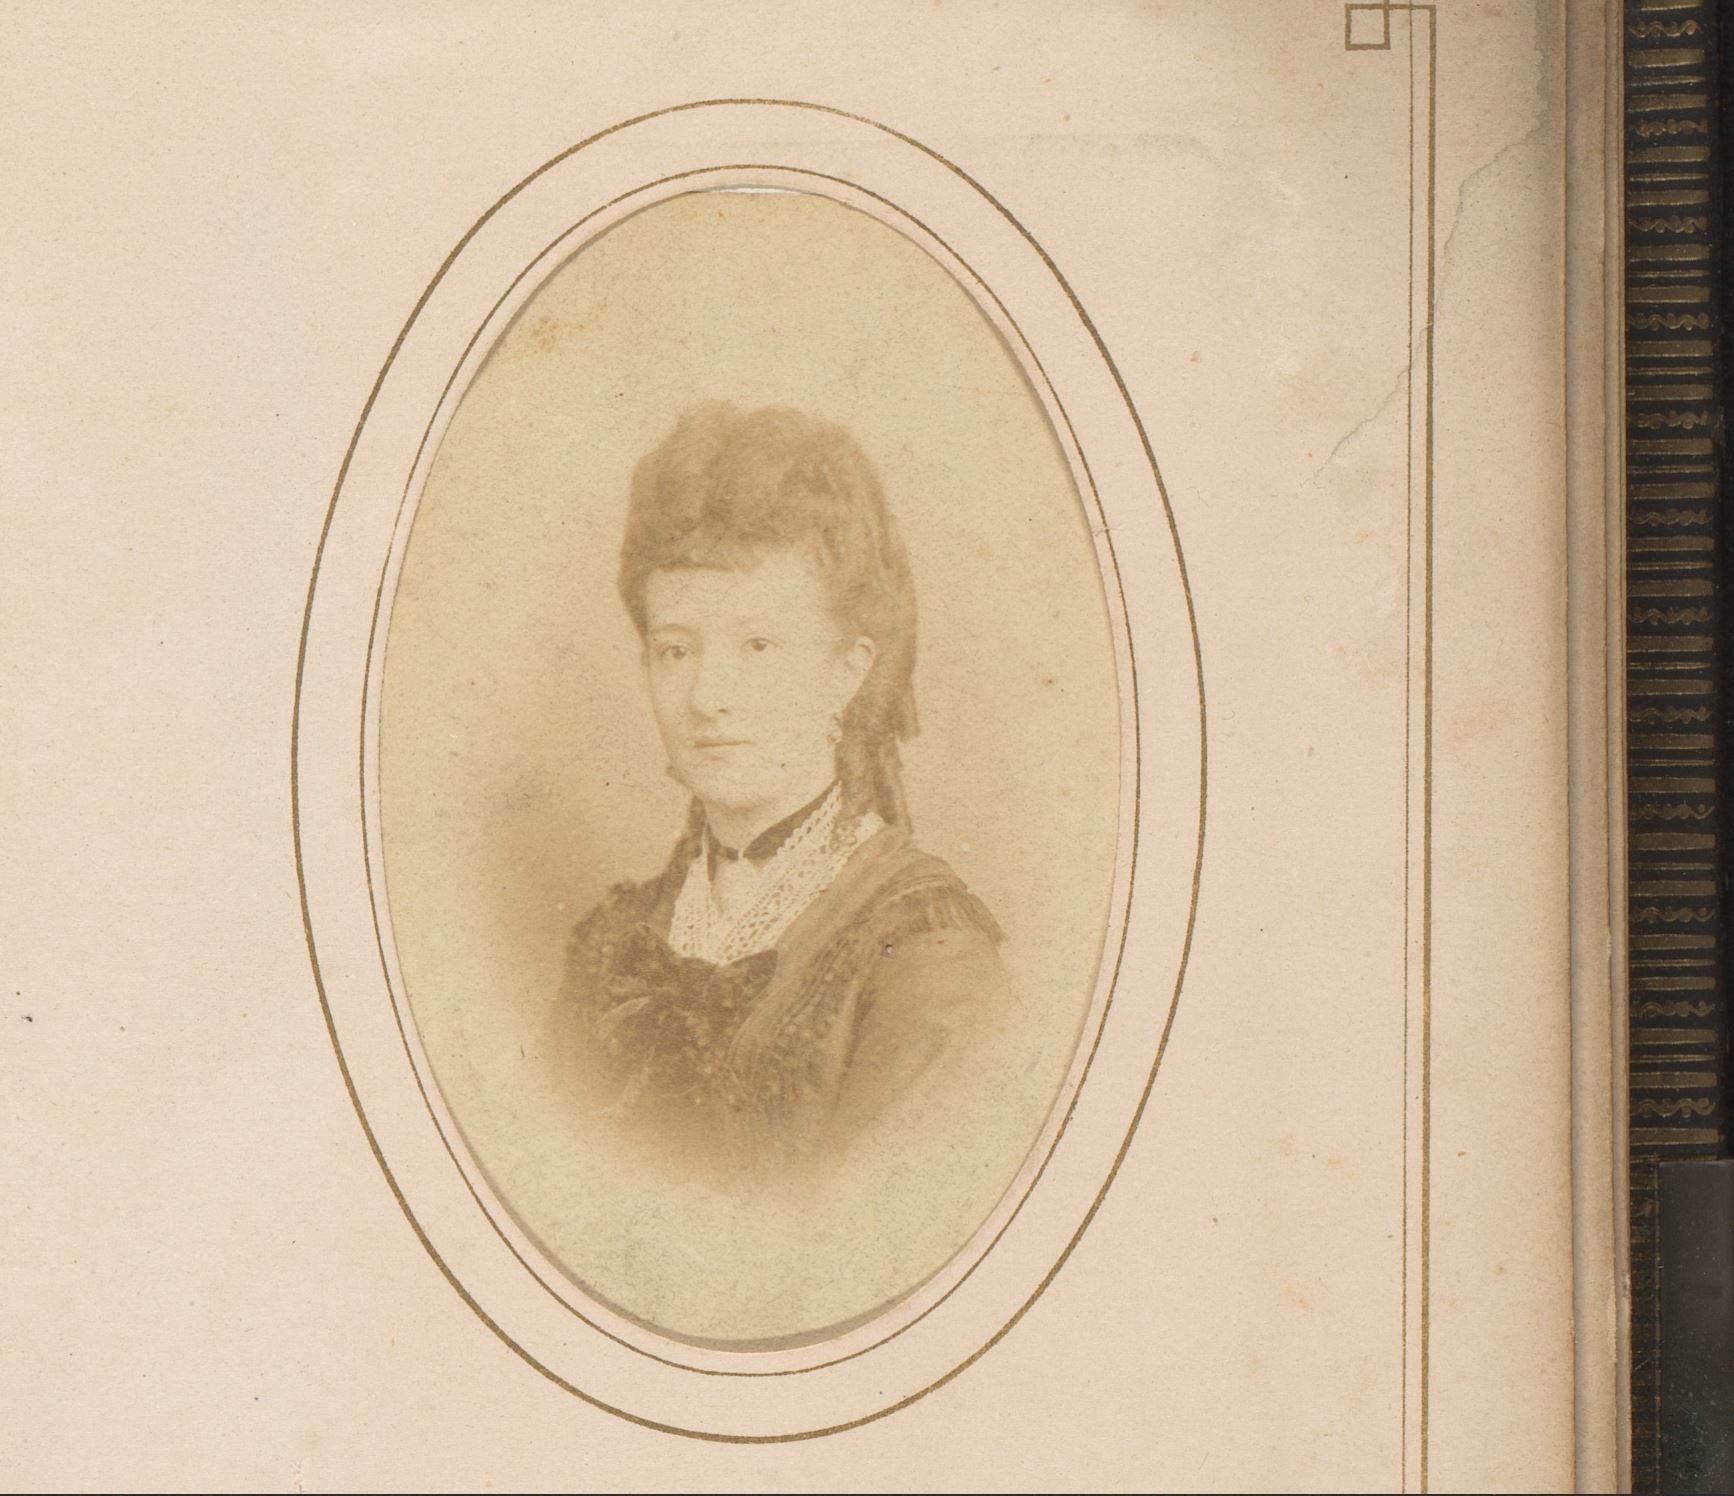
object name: cabinet photograph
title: Portret van jonge vrouw, aangeduid als Marie Sablairolles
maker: johannes wilhelmus franciscus offenberg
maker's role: fotograaf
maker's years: 1839-1919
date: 1867-1888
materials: cardboard, photographic support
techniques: albumen print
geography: amsterdam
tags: adolescent, young woman, maiden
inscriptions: annotation: ‘Vriendschappelijk aangeboden aan Gertrude Donker/ door Marie Sablairolles’, inscription: ‘Offenberg/ Photographe/ De S.M. La reine des Pays-Bas/ Damstraat/ Amsterdam’